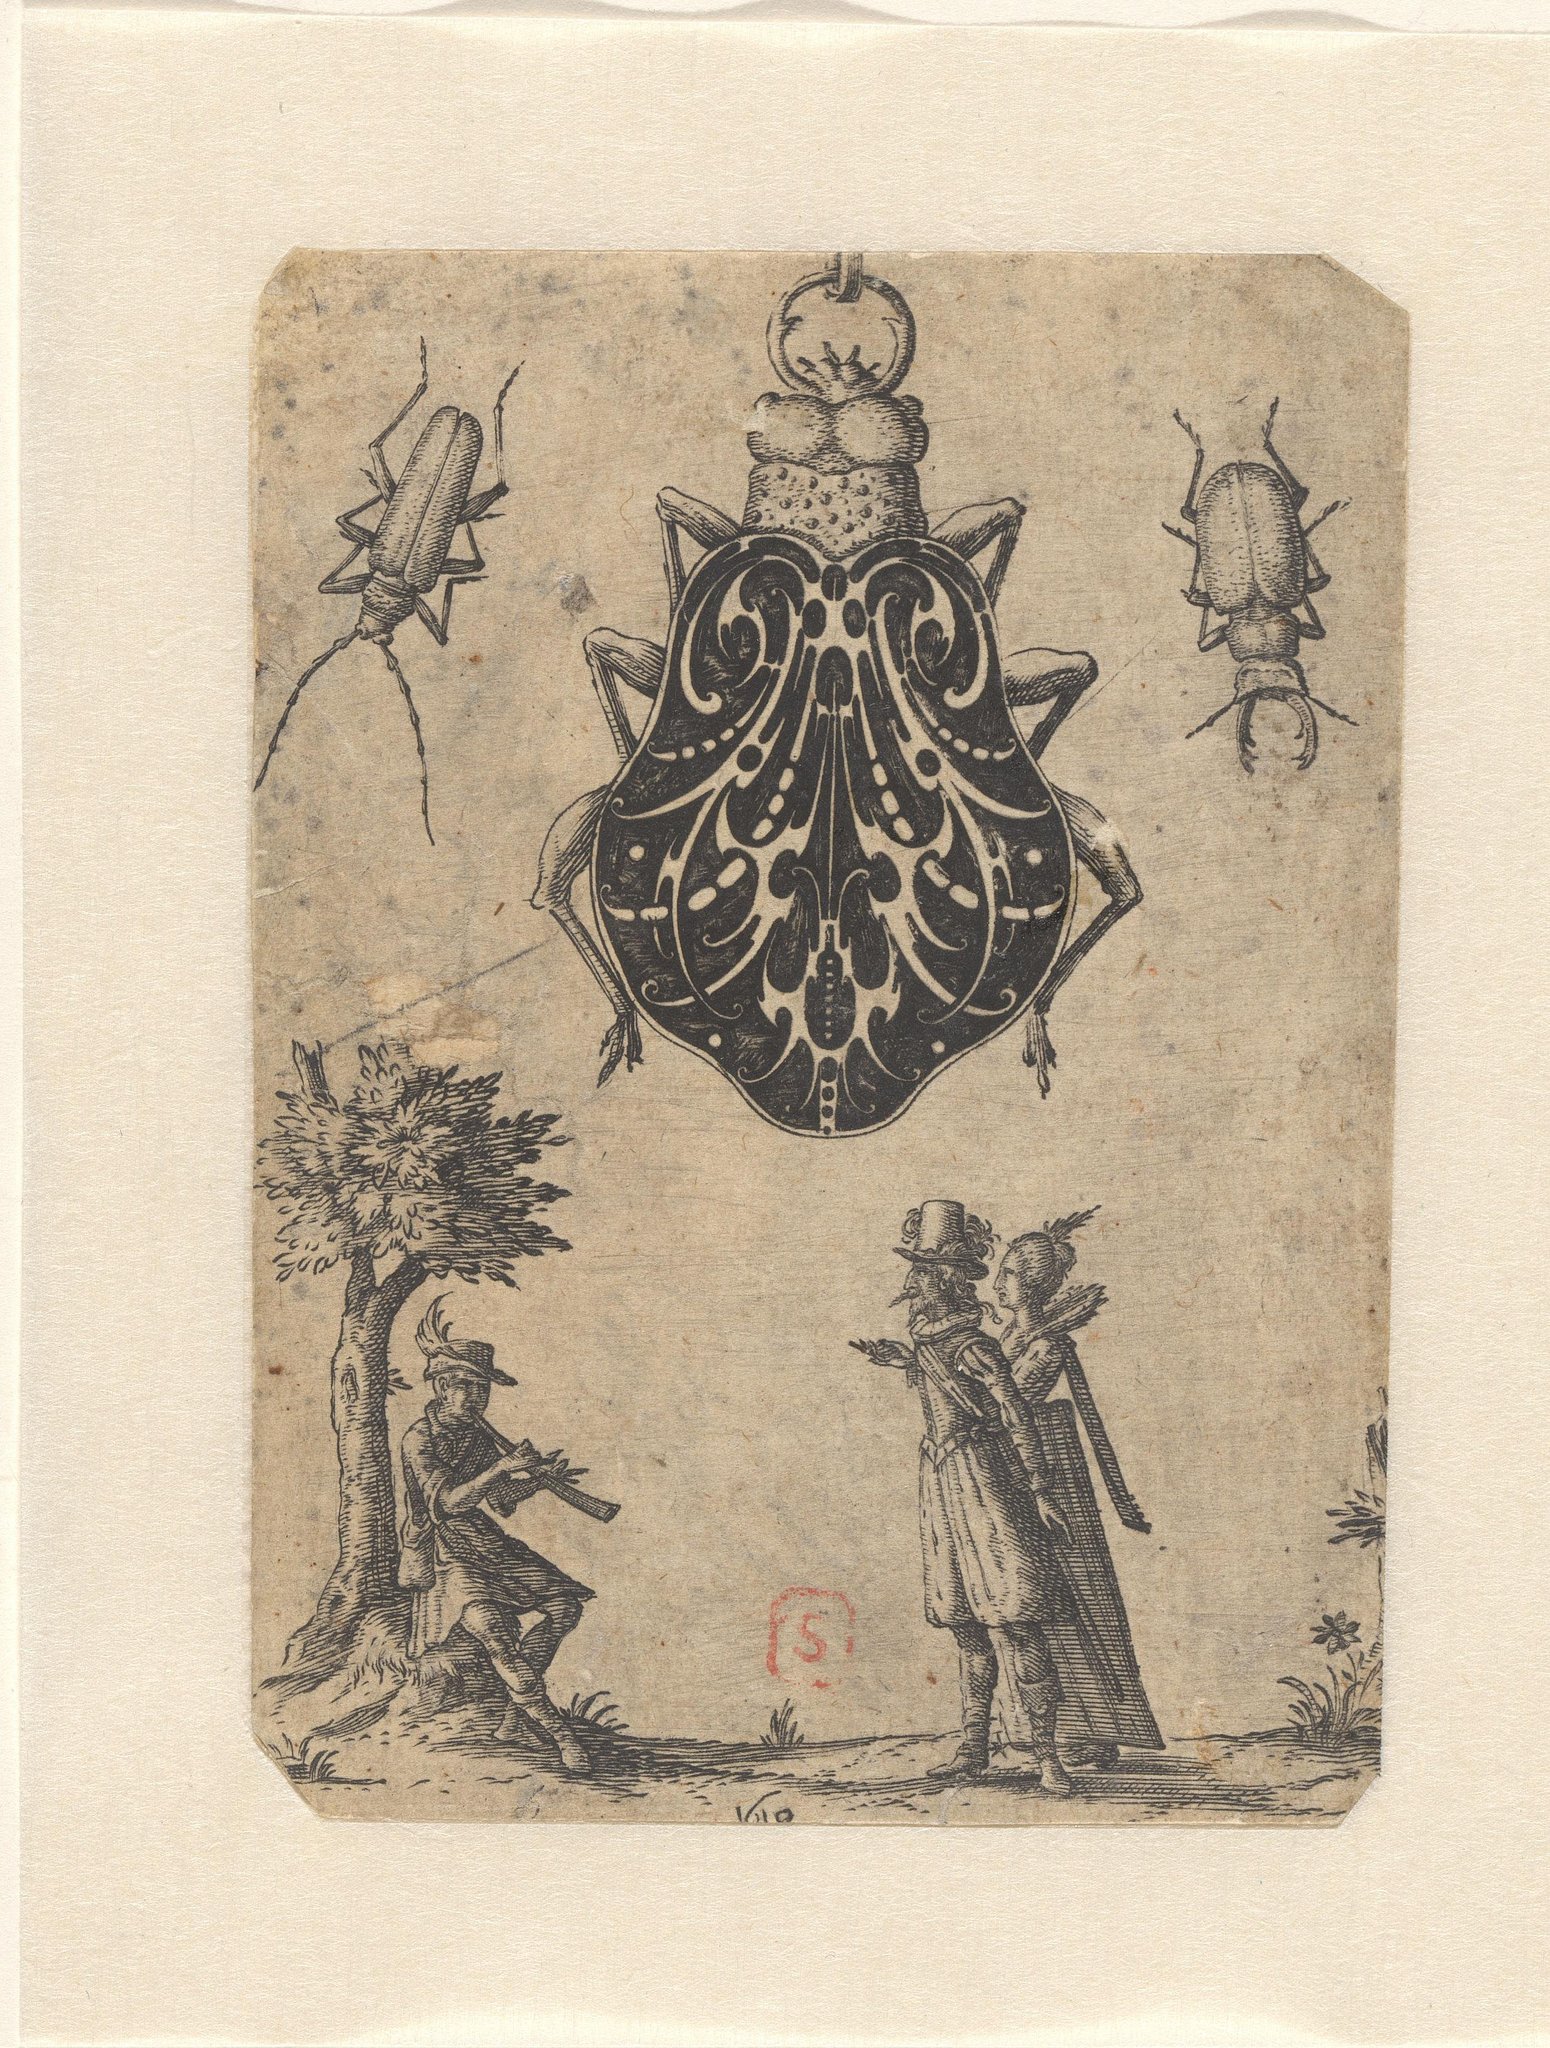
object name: ornament print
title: Zwartwerk ornament in de vorm van een kever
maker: jean toutin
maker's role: print maker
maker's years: 1578-1644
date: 1619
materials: paper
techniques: engraving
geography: paris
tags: ornament derived from animal forms, one person playing wind instrument - cc - out of doors, insects: beetle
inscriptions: collector's mark: Lugt 2342, collector's mark: Lugt 2228, collector's mark: Lugt 2760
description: Zwartwerk ornament in de vorm van een kever. Links en rechts een kleine kever. Onder hen een dame en heer, staand voor een speelman die een blaasinstrument bespeelt. Onderdeel van een serie ornamentprenten voor goudsmeden en emailleurs.